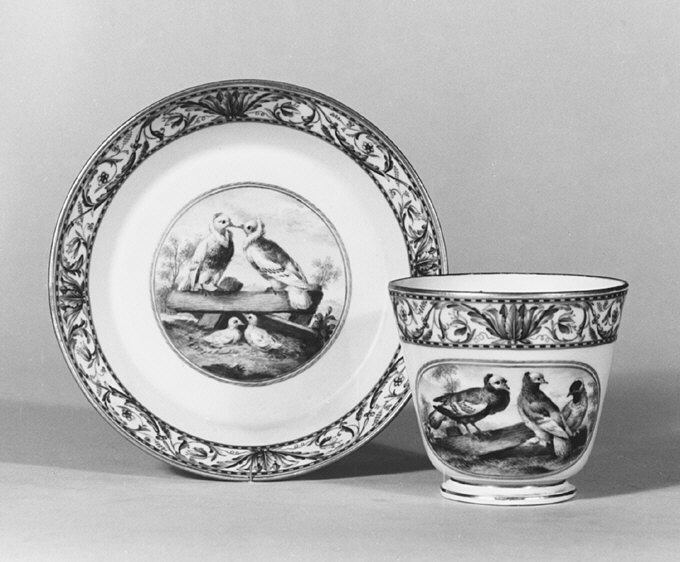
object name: coffee cup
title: Coffee cup (part of a service)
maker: meissen manufactory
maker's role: manufactory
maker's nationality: german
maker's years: 1710-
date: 1780-1785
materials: hard paste porcelain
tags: birds,trees